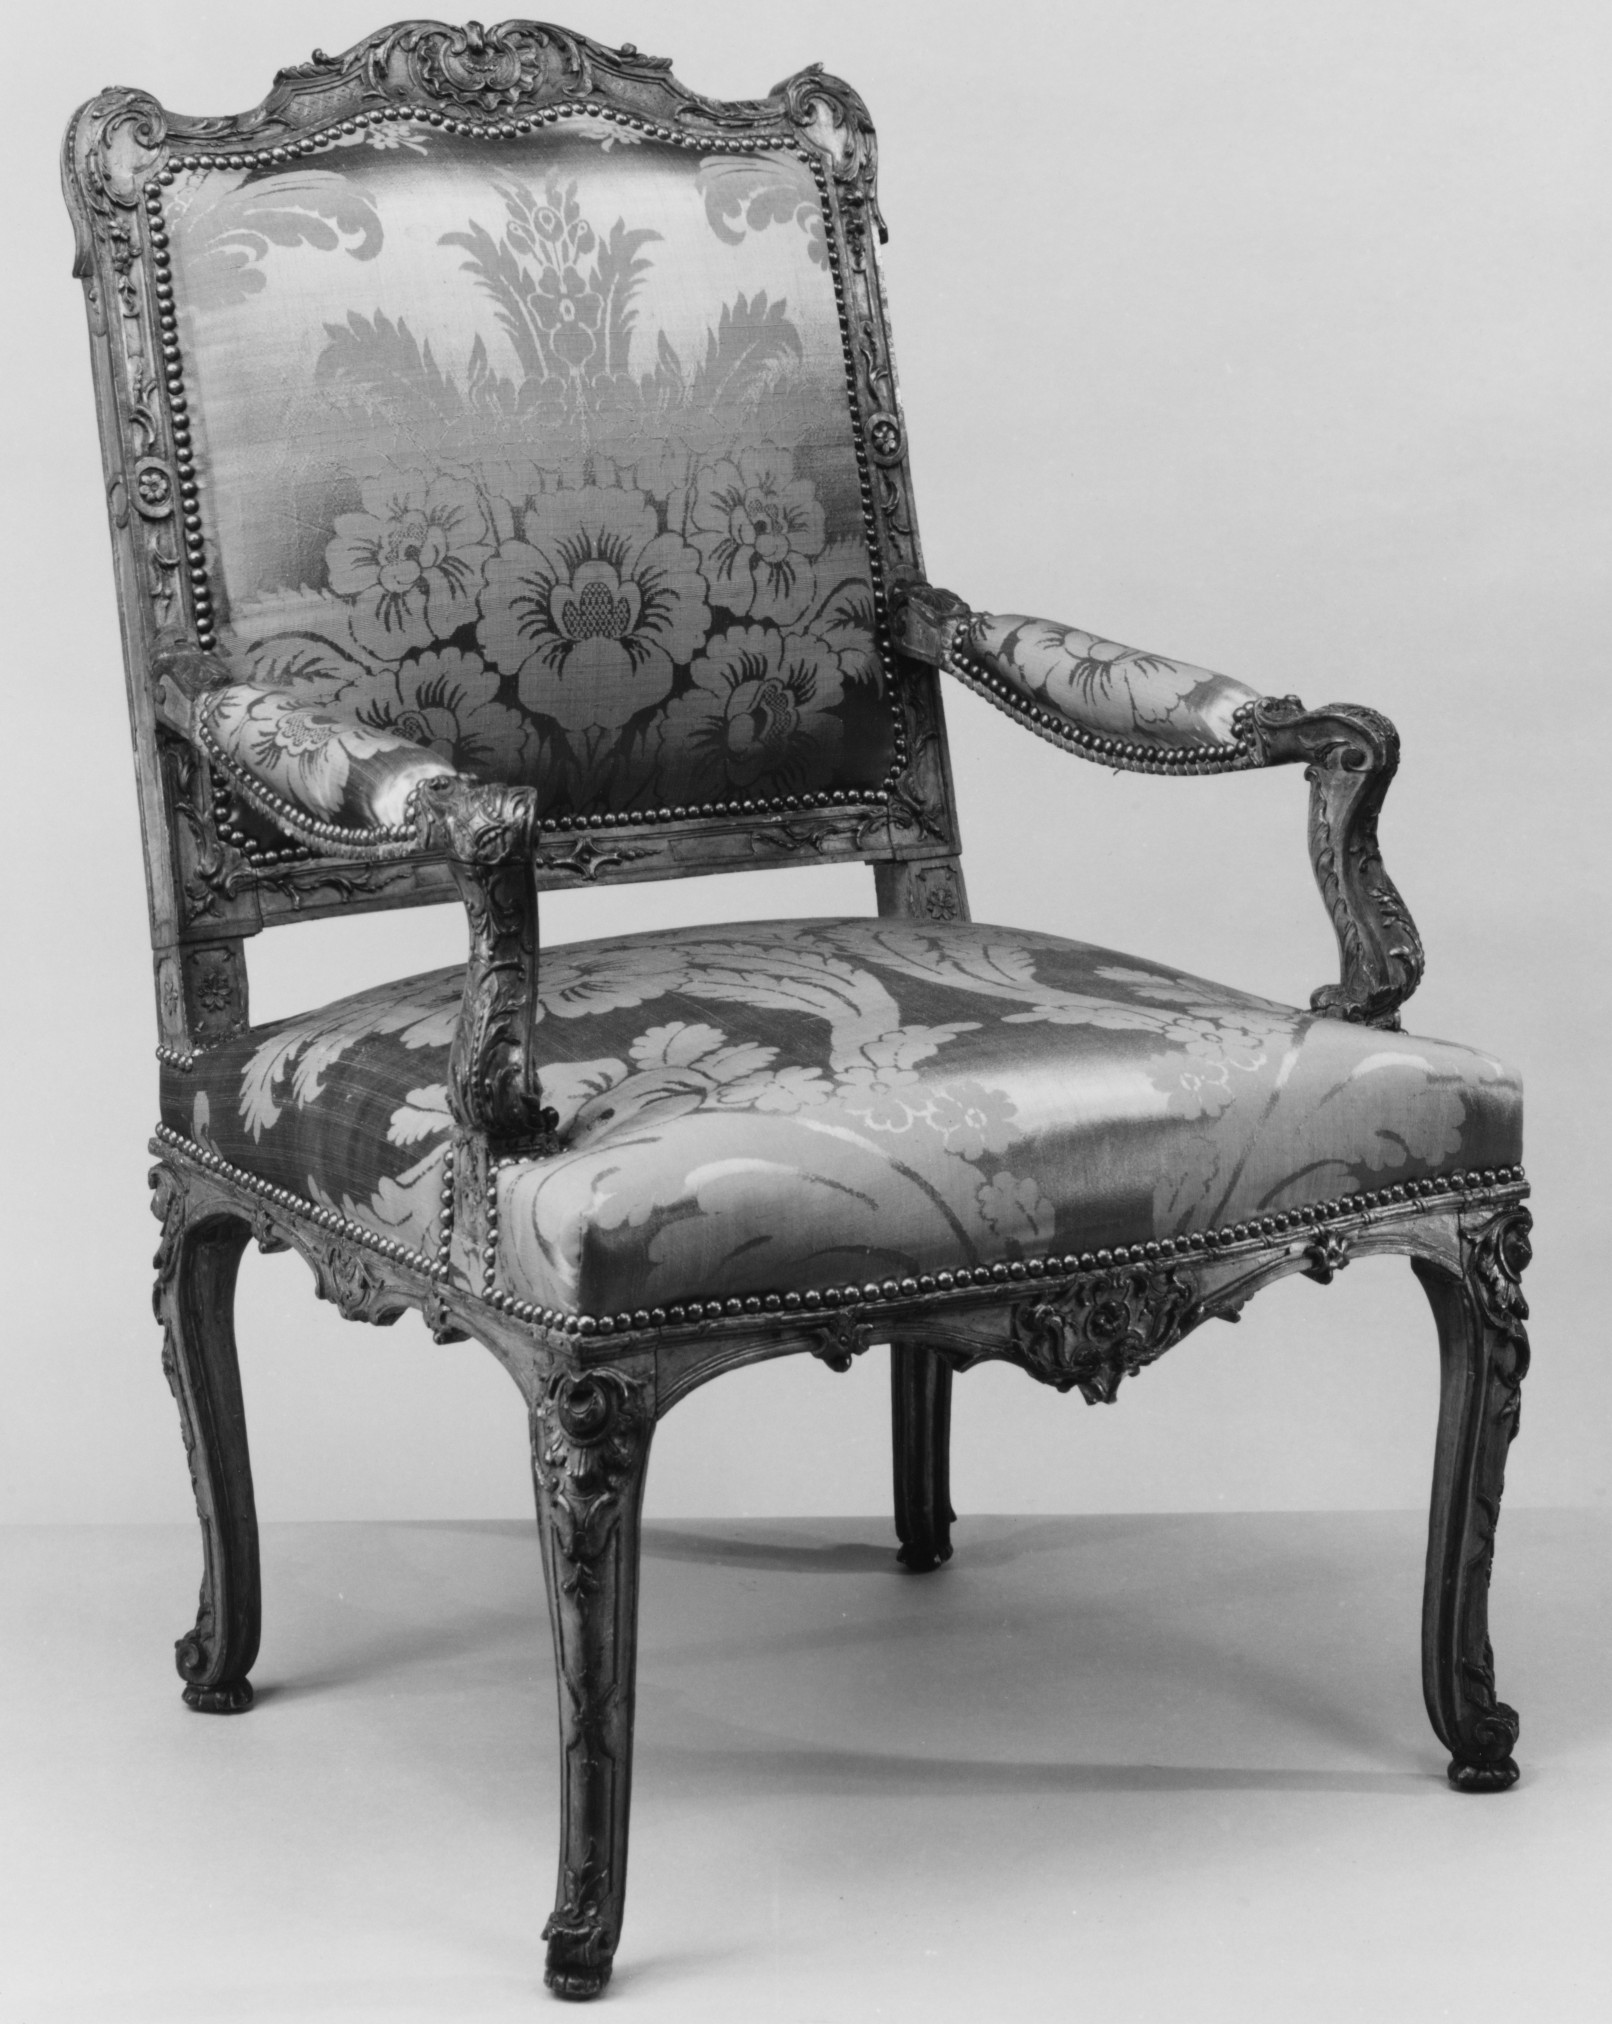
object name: armchair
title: Armchair (part of a set)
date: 1701-1725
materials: wood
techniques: carving, damask